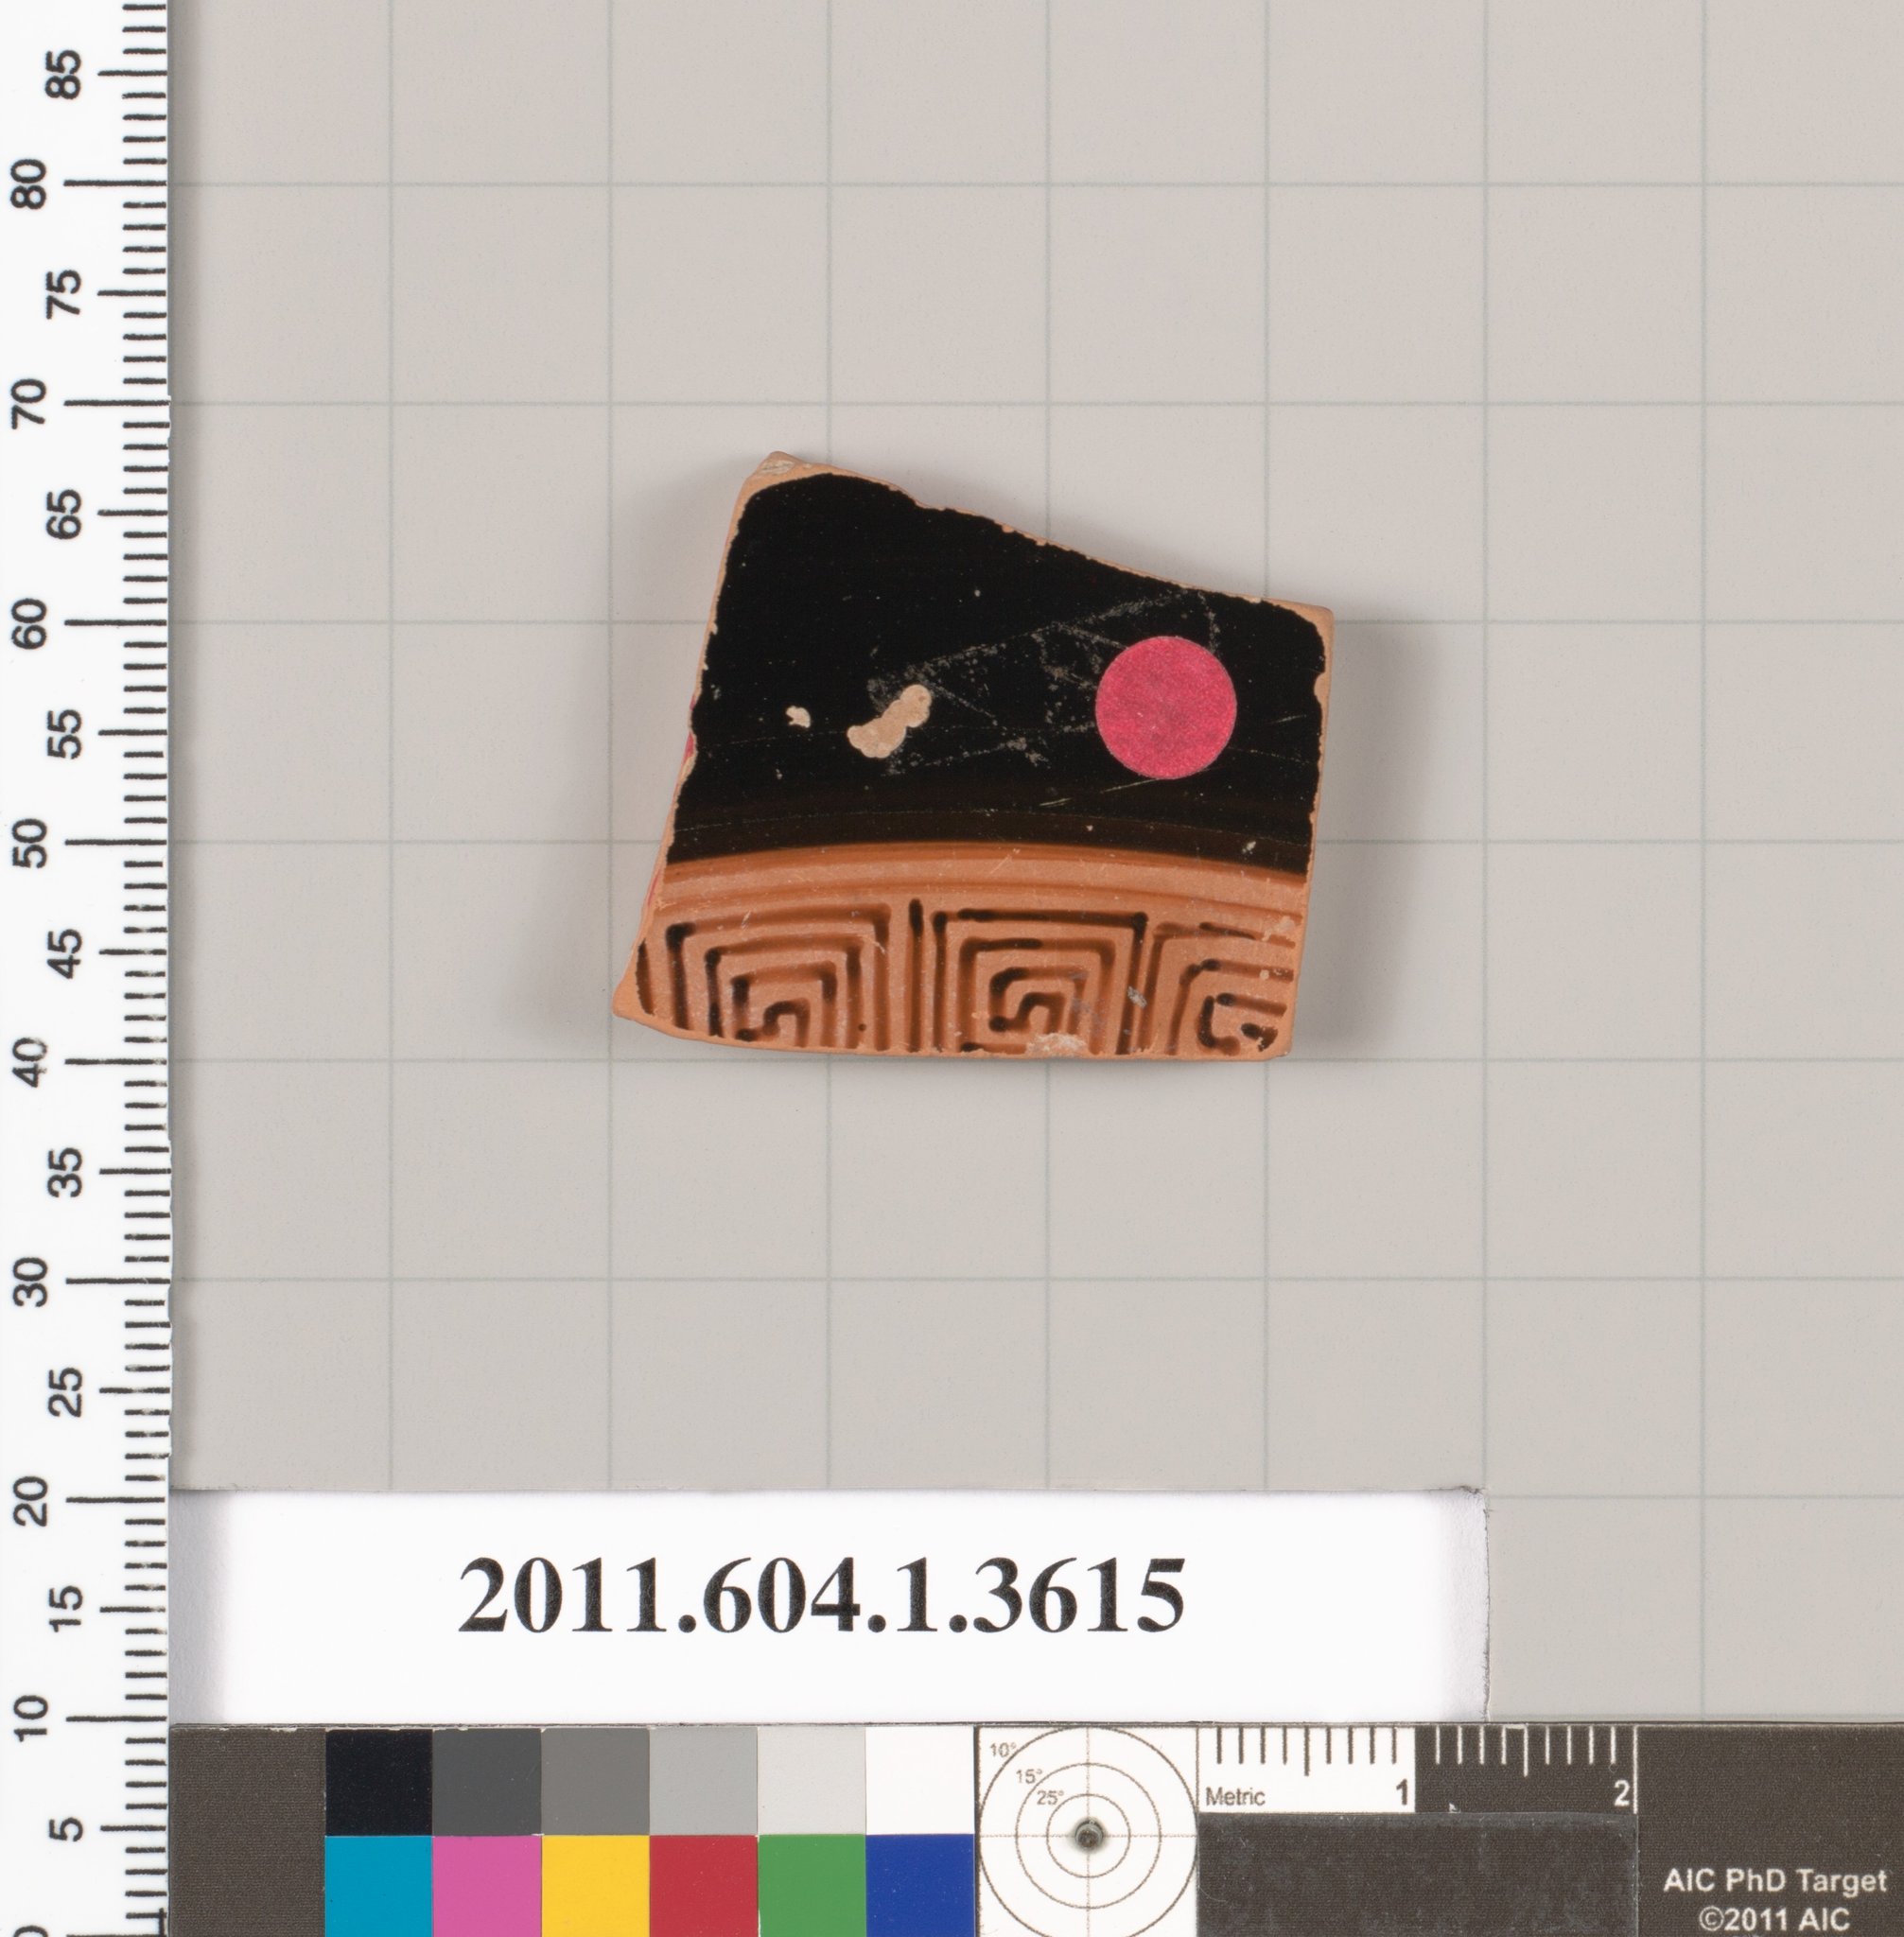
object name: kylix fragment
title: Terracotta fragment of a kylix (drinking cup)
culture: greek, attic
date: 475-451 BCE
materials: terracotta